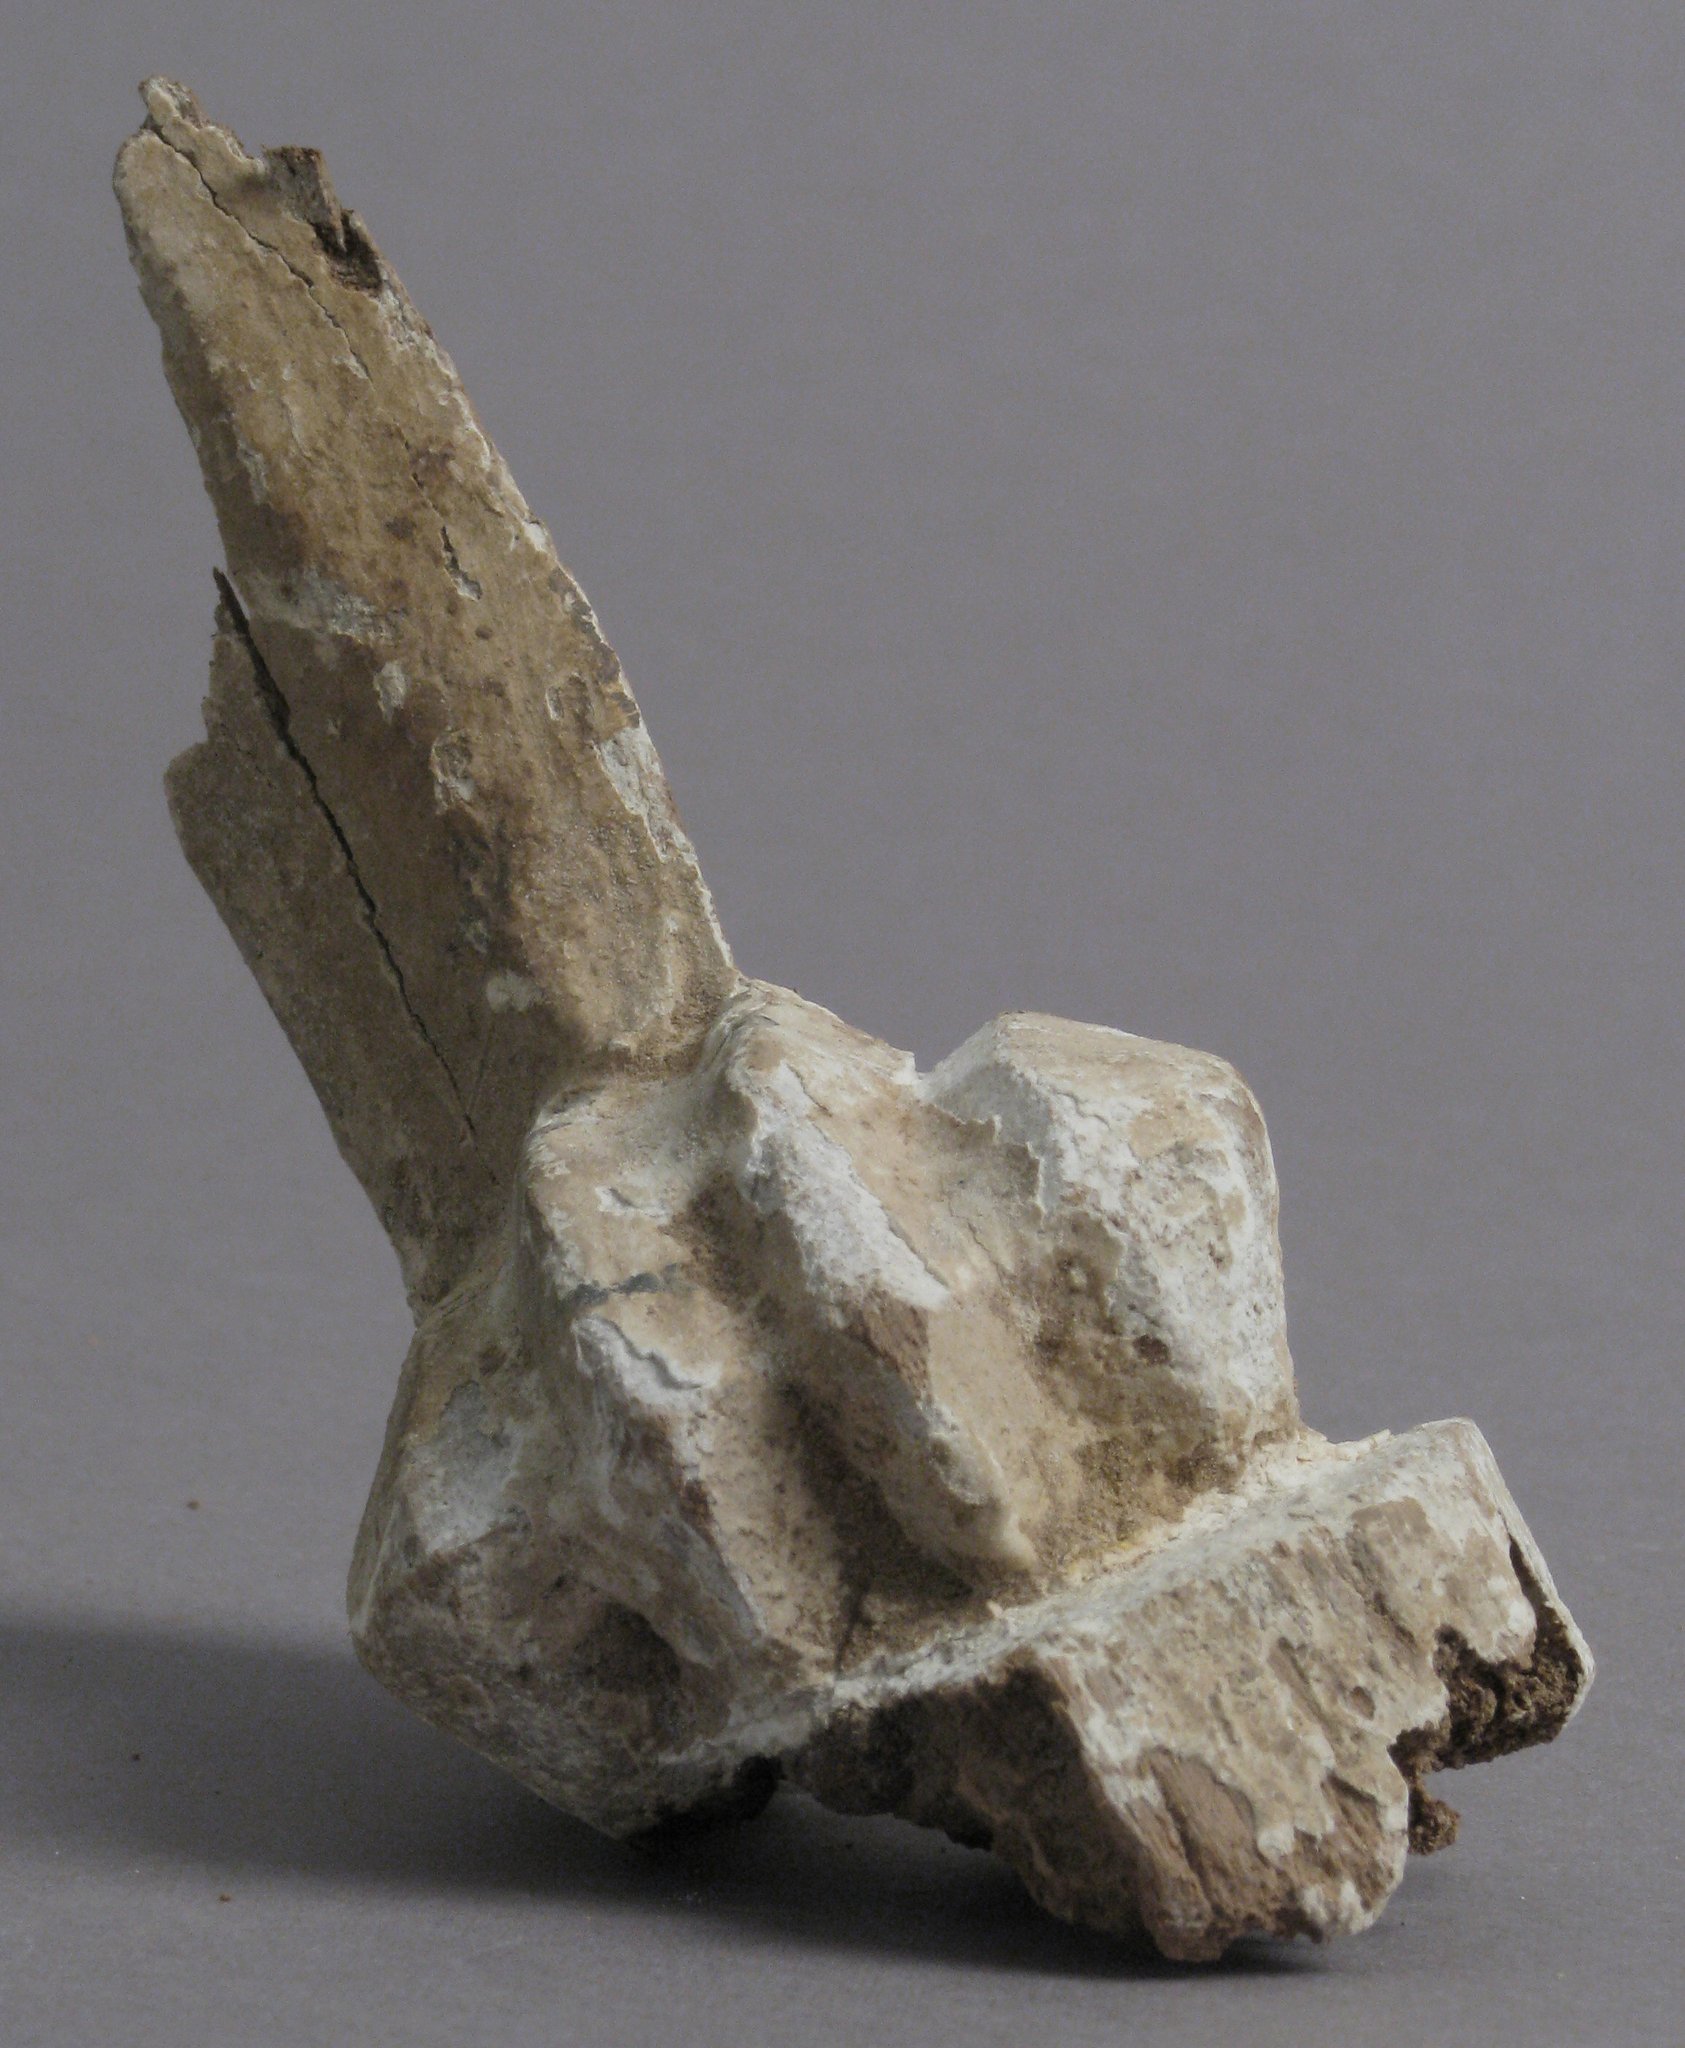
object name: statuette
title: Claw Fragment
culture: coptic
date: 301-700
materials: wood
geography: egypt